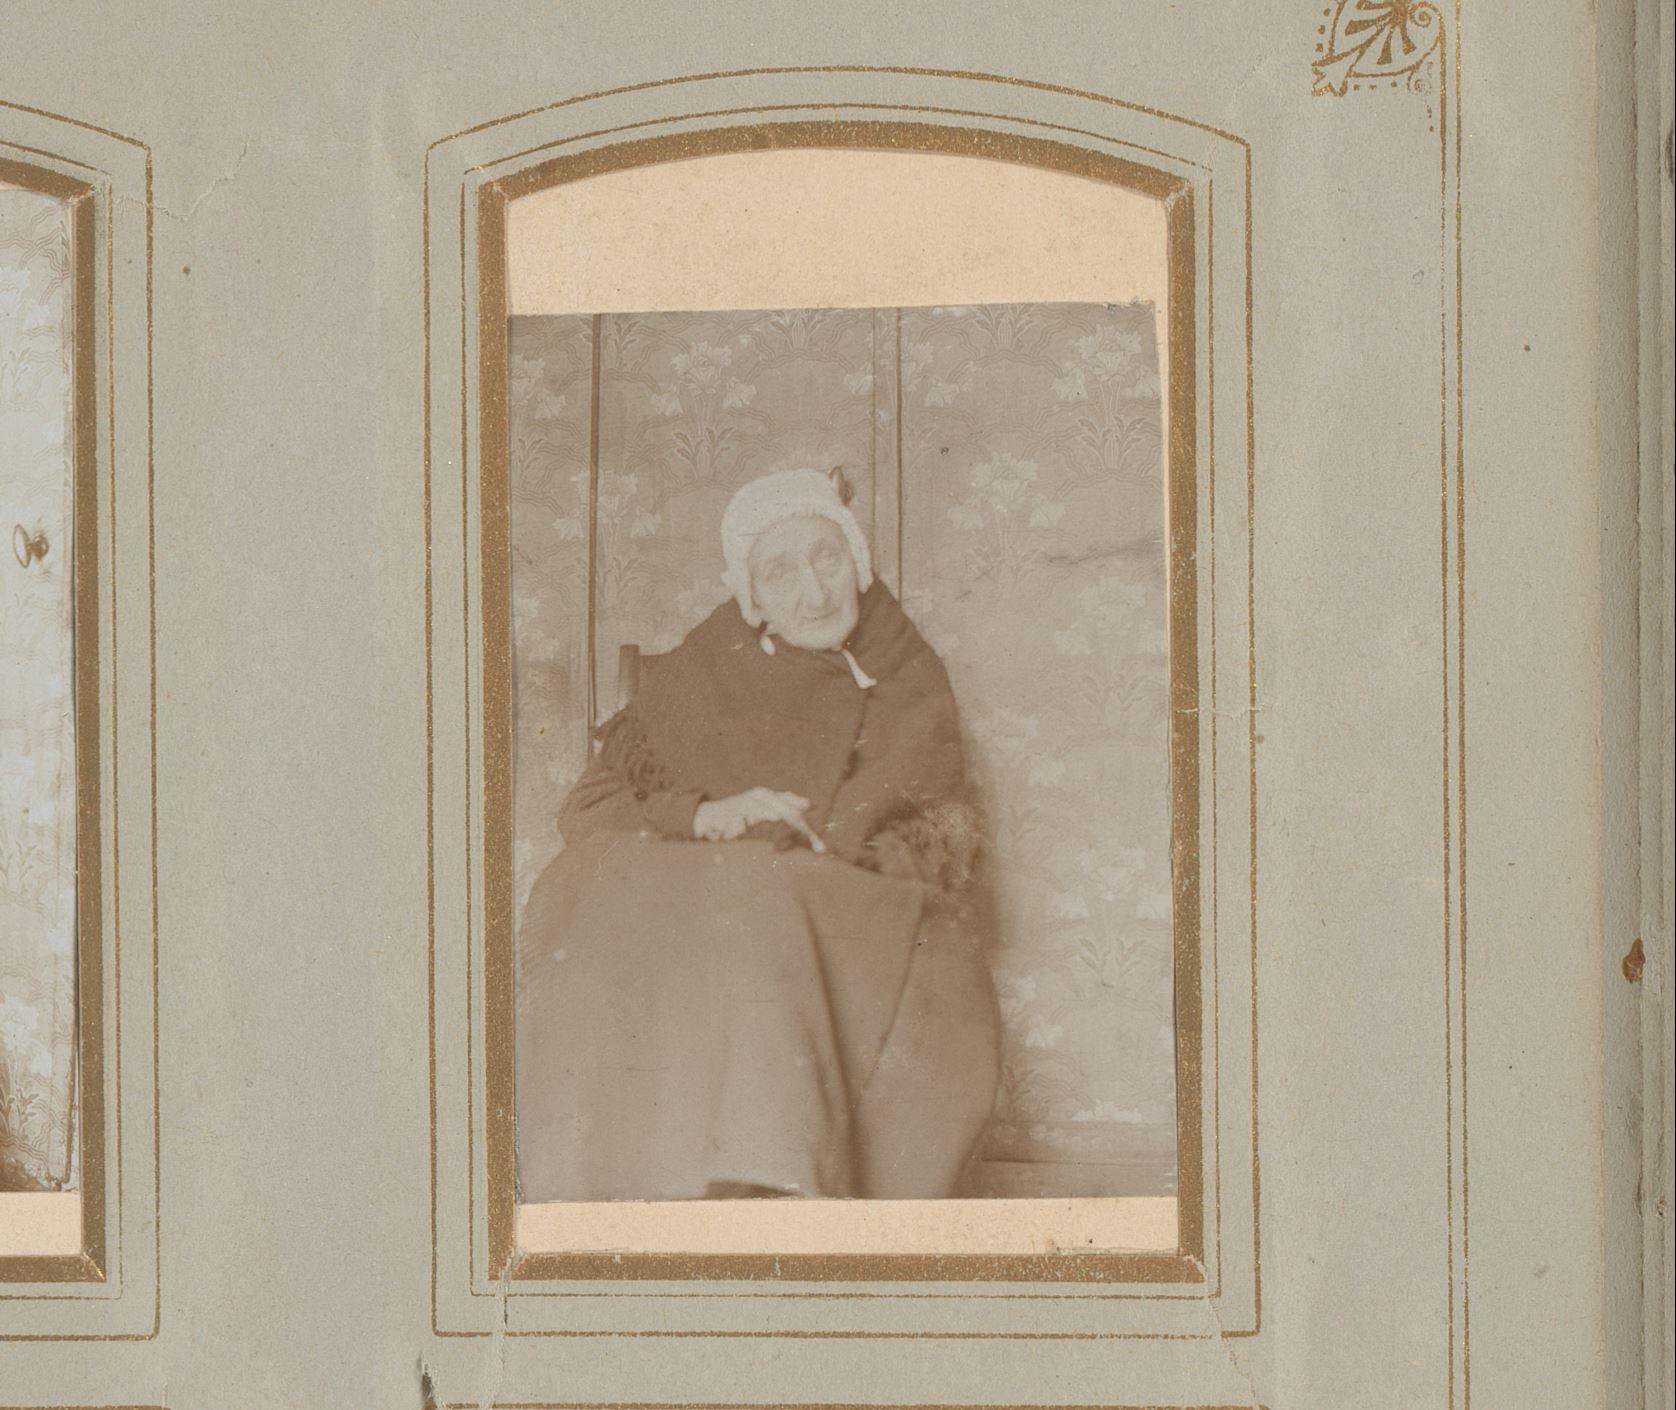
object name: carte de visite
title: Portret van een oude vrouw in een stoel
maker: Anonymous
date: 1880-1920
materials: cardboard, photographic support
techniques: collodion silver print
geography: netherlands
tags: sitting figure - aa - female human figure, historical persons - bb - woman, old woman, chair